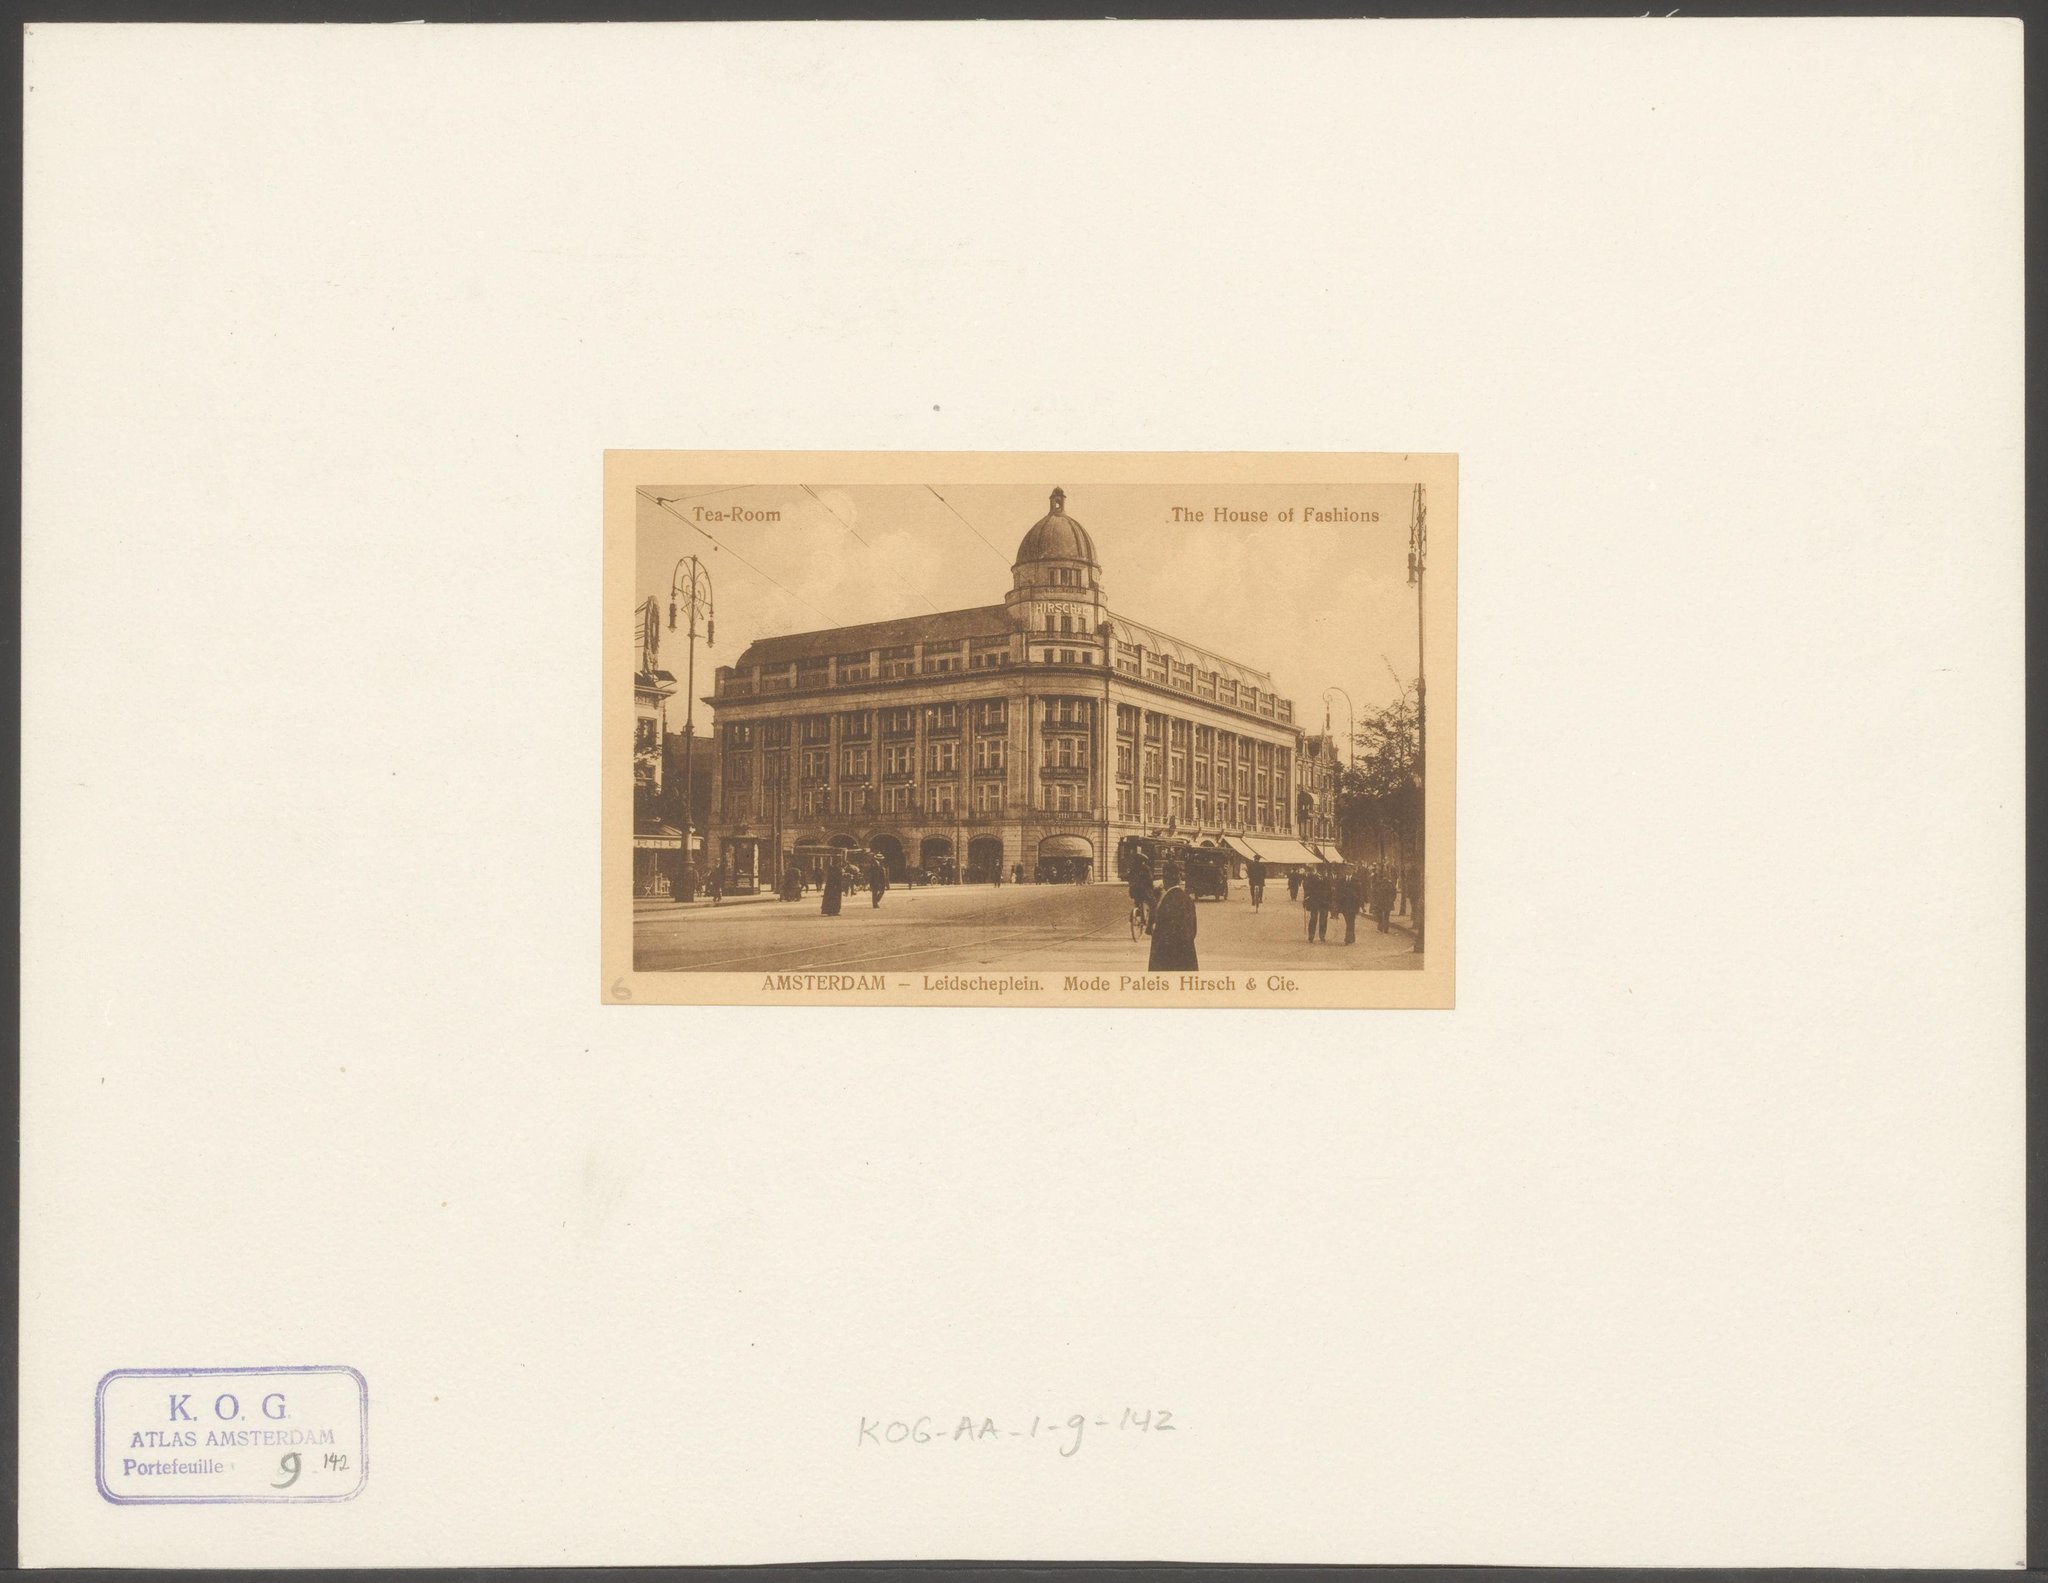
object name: ansichtkaart, prentbriefkaart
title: Gezicht op Hirsch & Co op het Leidseplein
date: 1905-1930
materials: cardboard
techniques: photograph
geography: amsterdam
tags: square, place, circus, etc., city-view in general; 'veduta', edifice, e.g.: public building, department store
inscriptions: collector's mark: ‘9.142’ Lugt 1641b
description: Onderwerpsrubriek binnen de Atlas Amsterdam: 2e Laurierdwarsstraat (Vuile Weespad), Leidschegracht, Leidschekade, Leidscheplein, Leidschestraat, v. Lennepkade, Lijnbaansgracht, Lauriergracht, Leliedwarsstraat, Leliegracht, Lindengracht, Lombardsteeg, Looiersgracht, Looiersstraat (Nieuwe), Leidekkerssteeg.